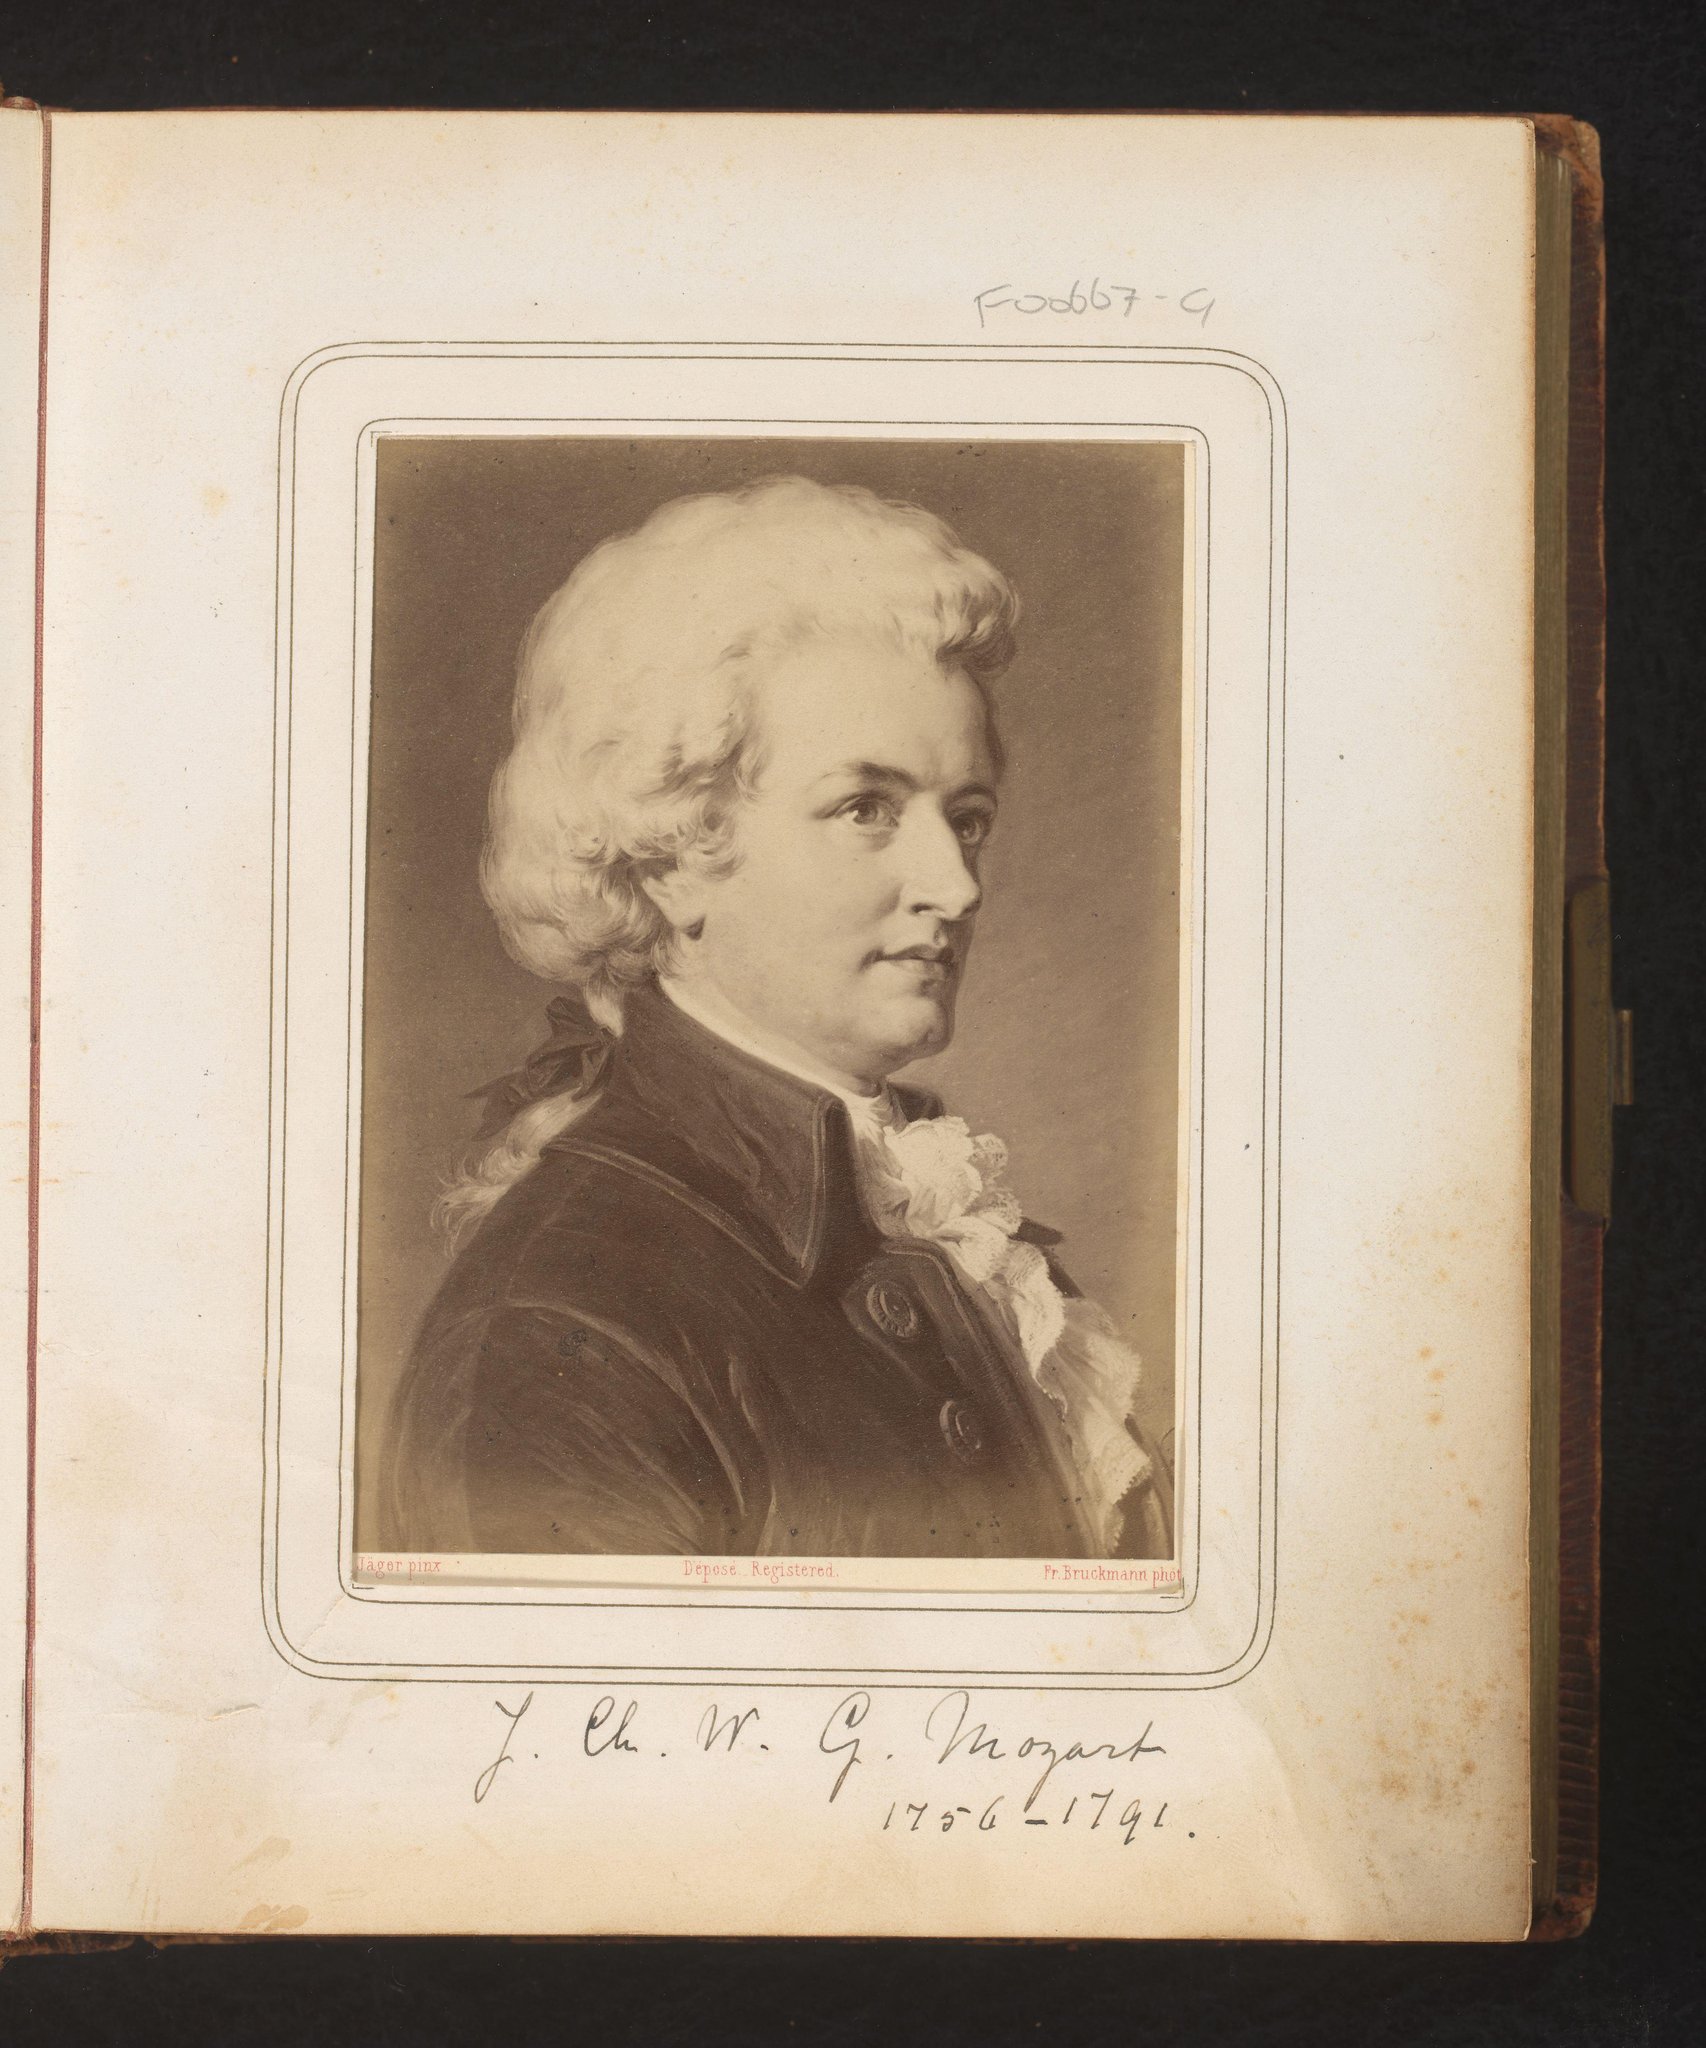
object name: album leaf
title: Fotoreproductie van een geschilderd portret van Wolfgang Amadeus Mozart door Carl Jaeger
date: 1870-1890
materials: cardboard, photographic support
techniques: albumen print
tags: vienna, historical persons, portrait of composer, picture, painting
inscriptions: annotation: ‘J. Ch. W. G. Mozart 1756 - 1791’, name: ‘Jäger pinx. Déposé Registered/ Fr. Bruckmann pho[...]’